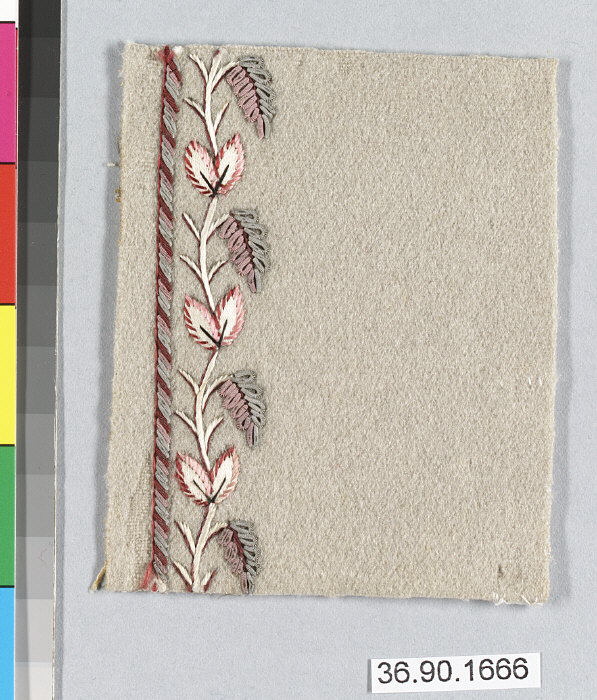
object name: sample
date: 1801-1833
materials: felt, metal thread, silk